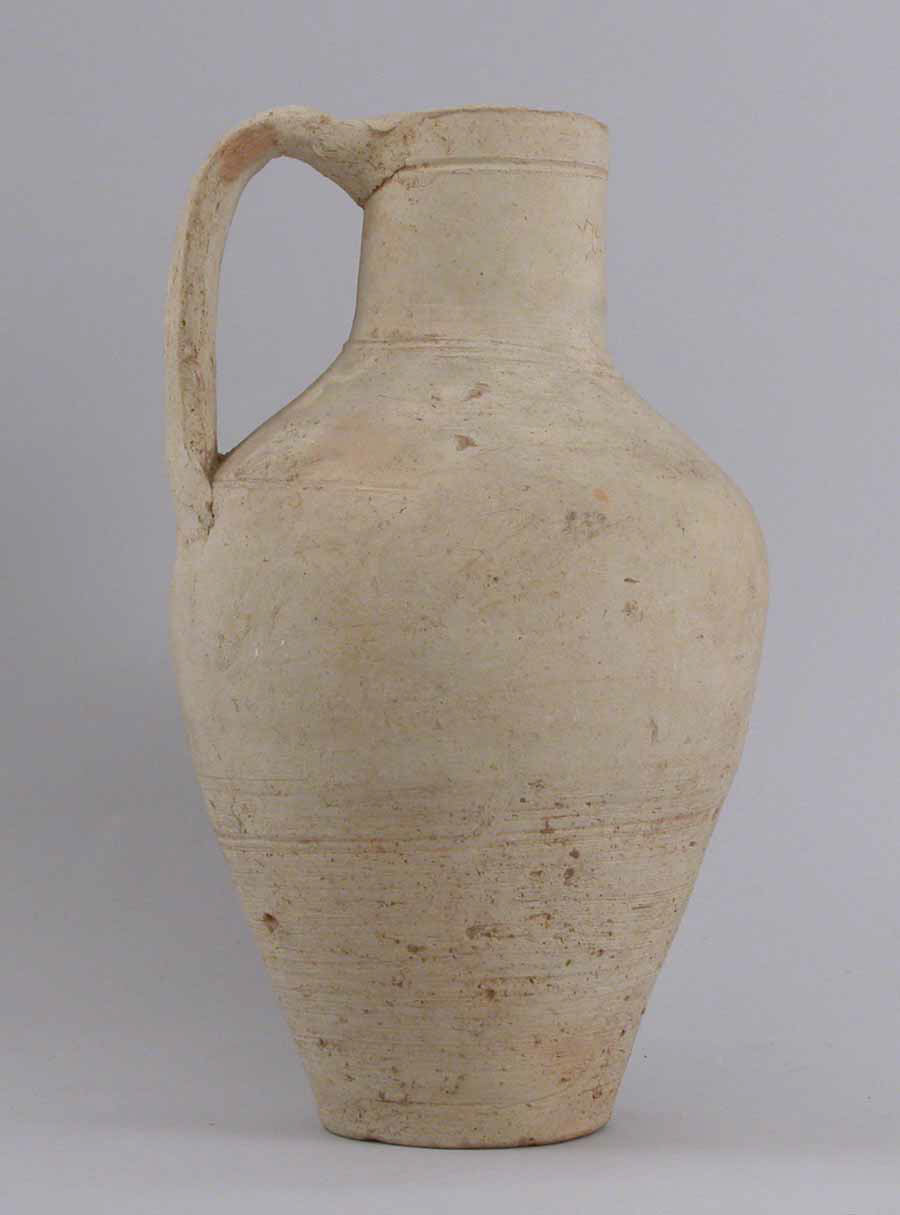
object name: jug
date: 801-900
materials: earthenware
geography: iran